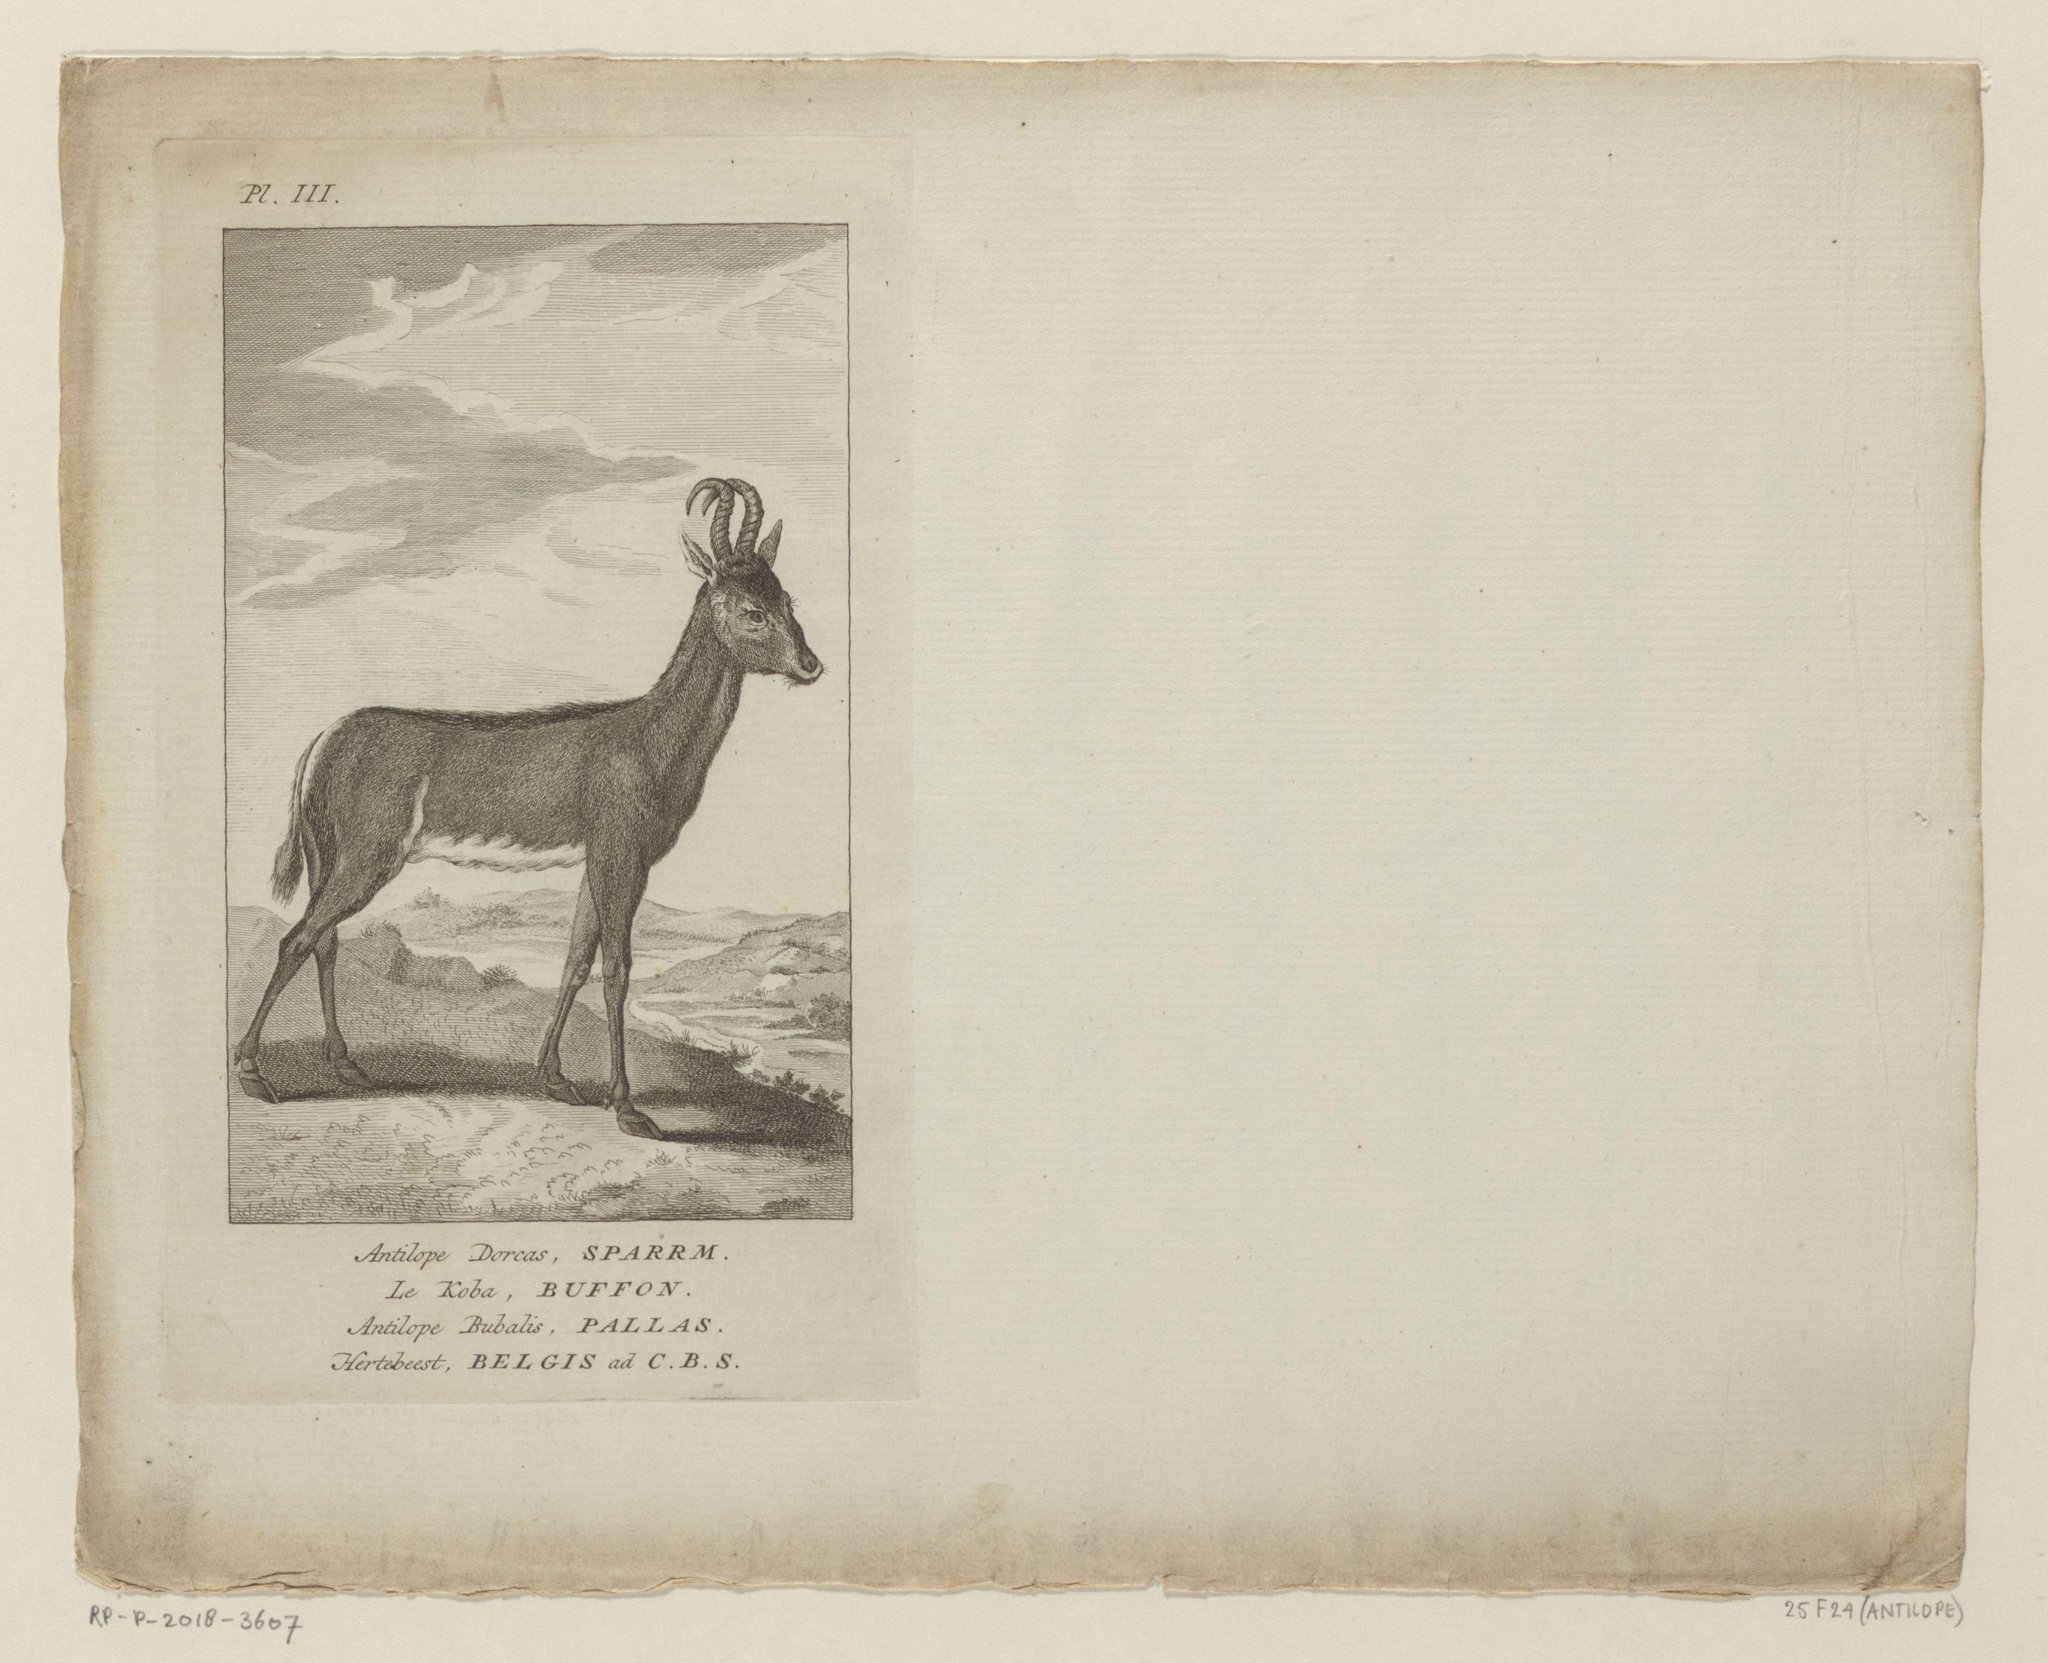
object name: print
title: Hartebeest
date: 1787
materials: paper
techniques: engraving, etching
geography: netherlands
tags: hoofed animals: antelope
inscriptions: collector's mark: Lugt 2228, watermark